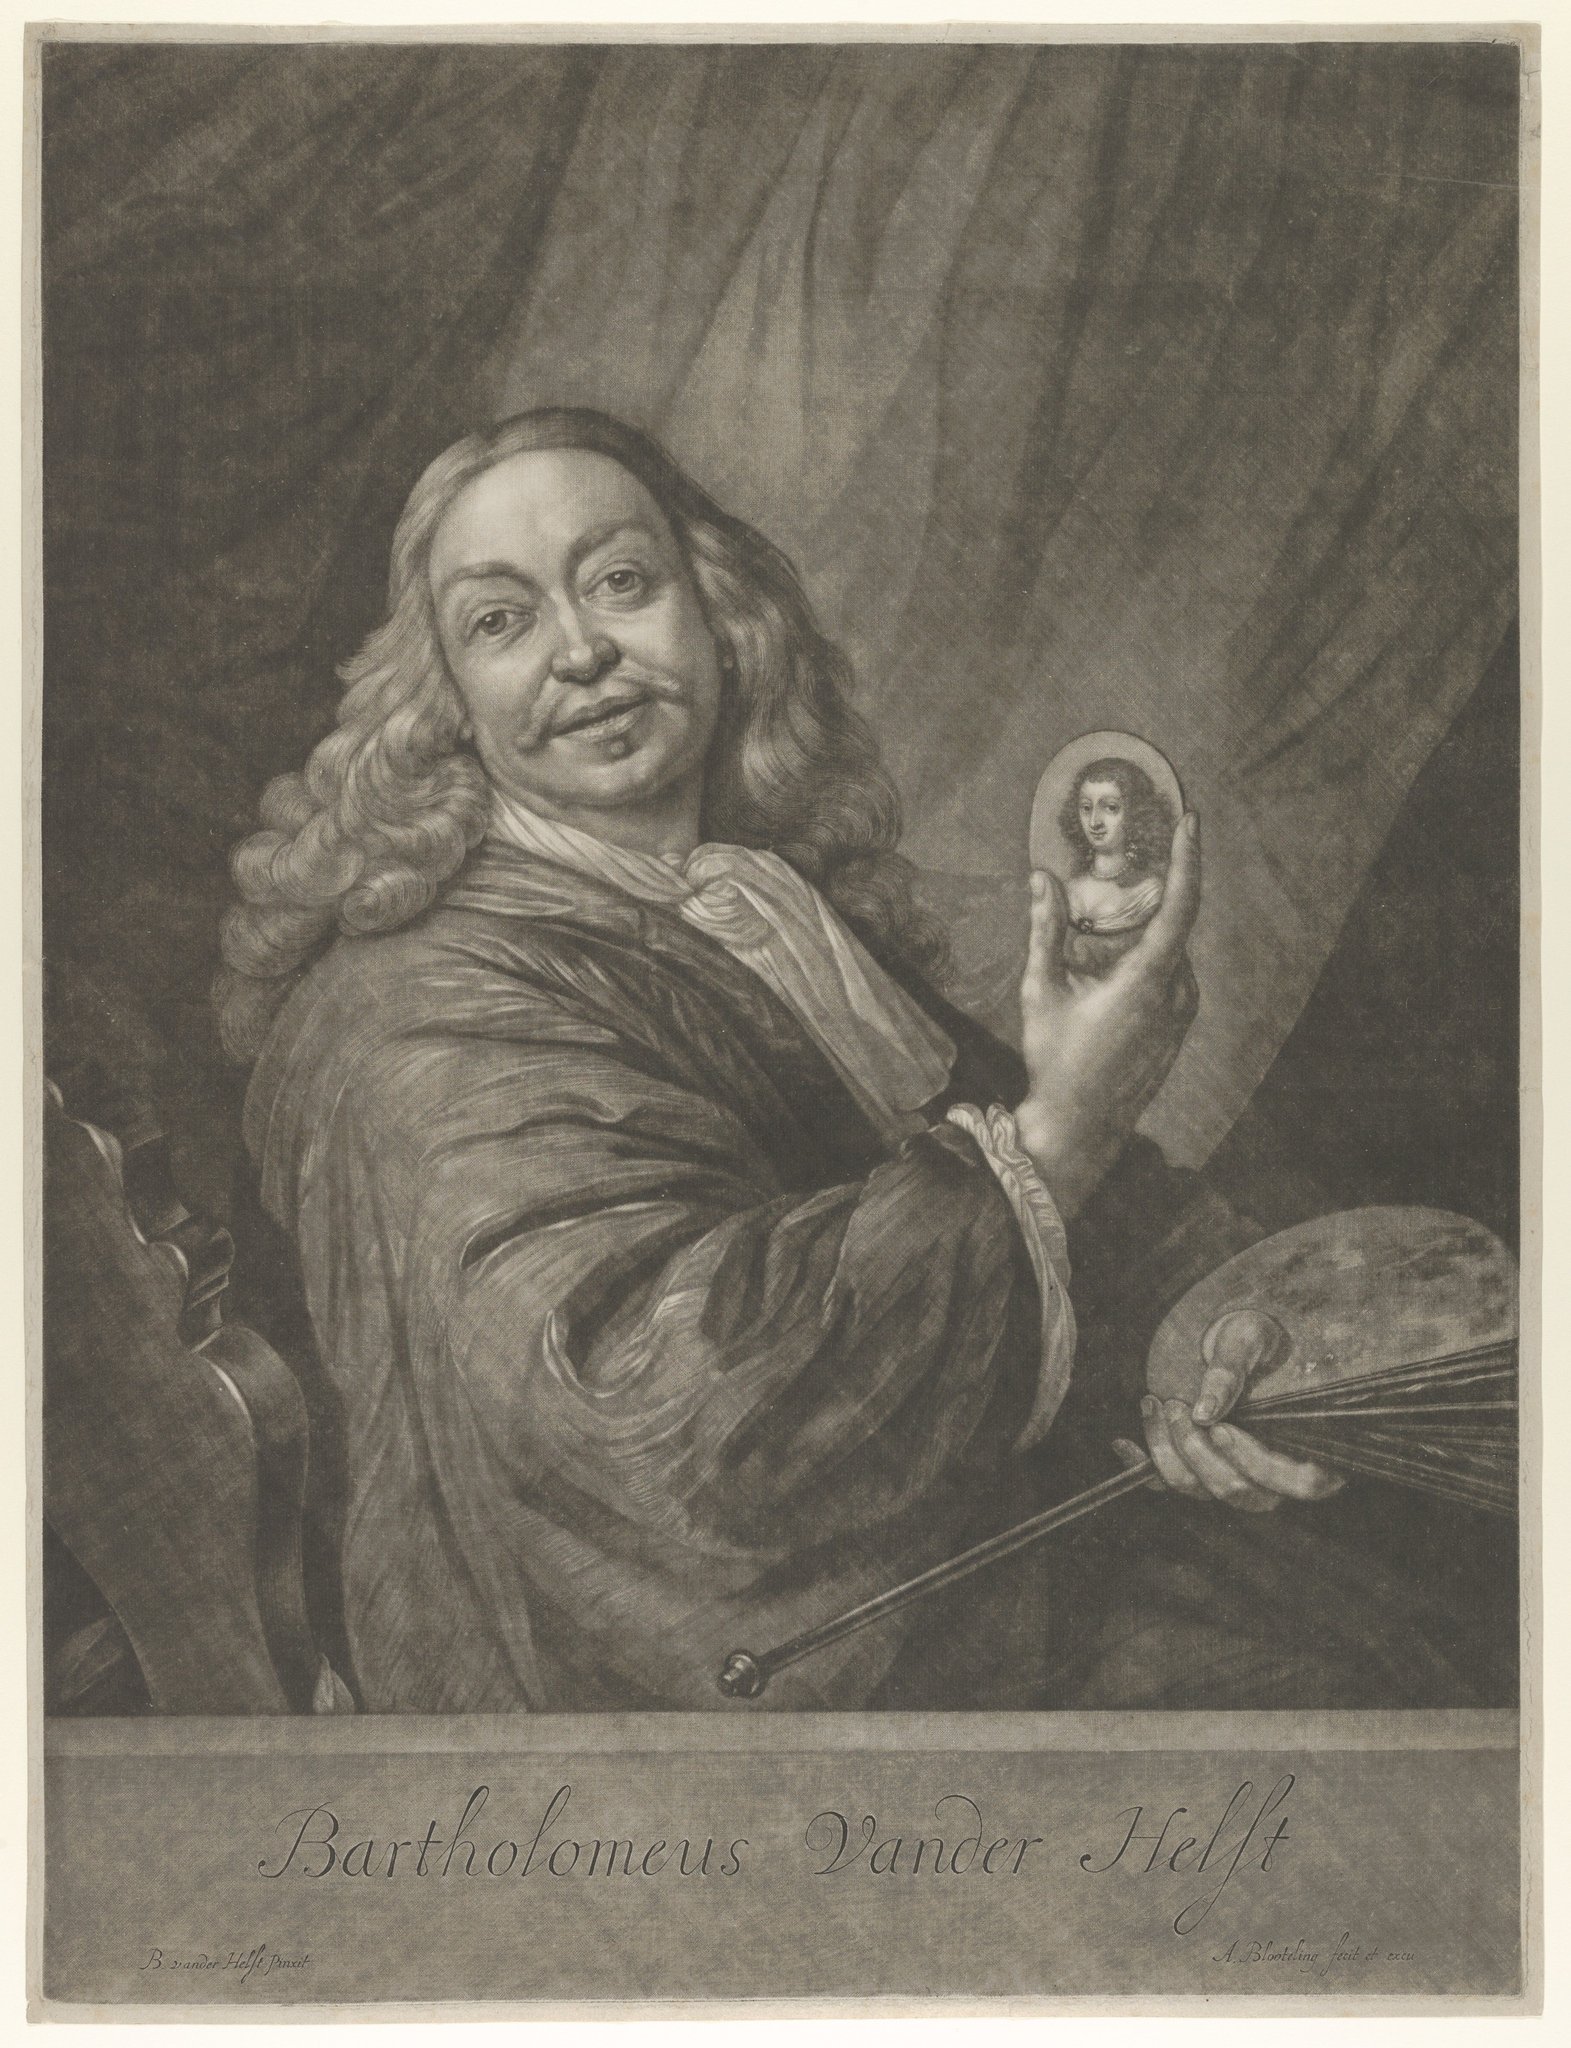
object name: print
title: Bartholomeus van der Helst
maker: abraham blooteling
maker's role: artist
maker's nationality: dutch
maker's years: 1640-1690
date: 1670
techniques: mezzotint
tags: men,portraits,palettes